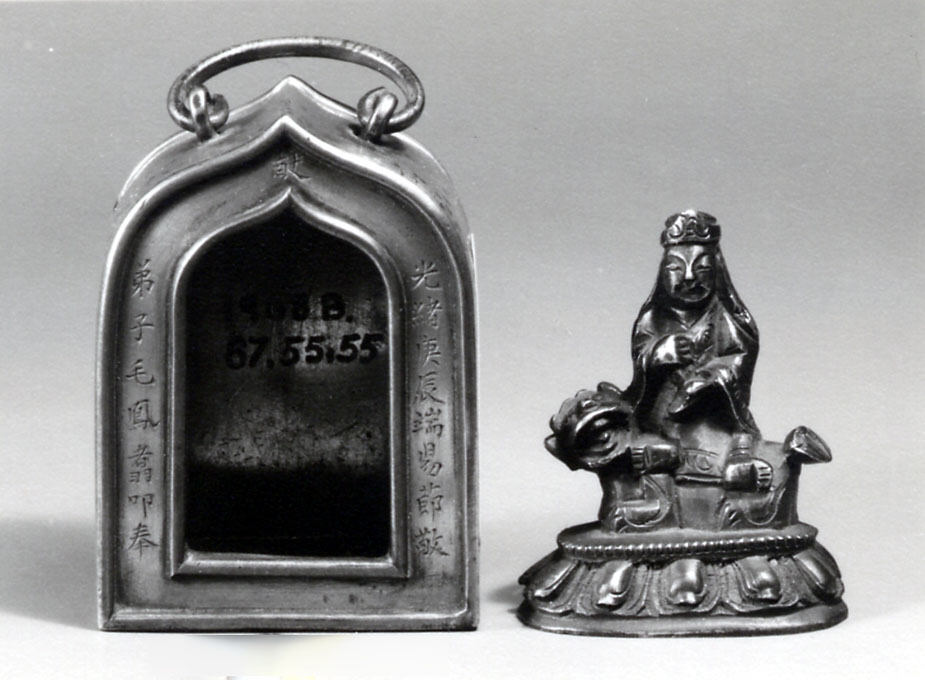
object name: traveller's shrine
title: Traveller's Shrine with Figure of Wenshu (Manjusri) on Lion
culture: chinese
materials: brass, pewter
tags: manjushri